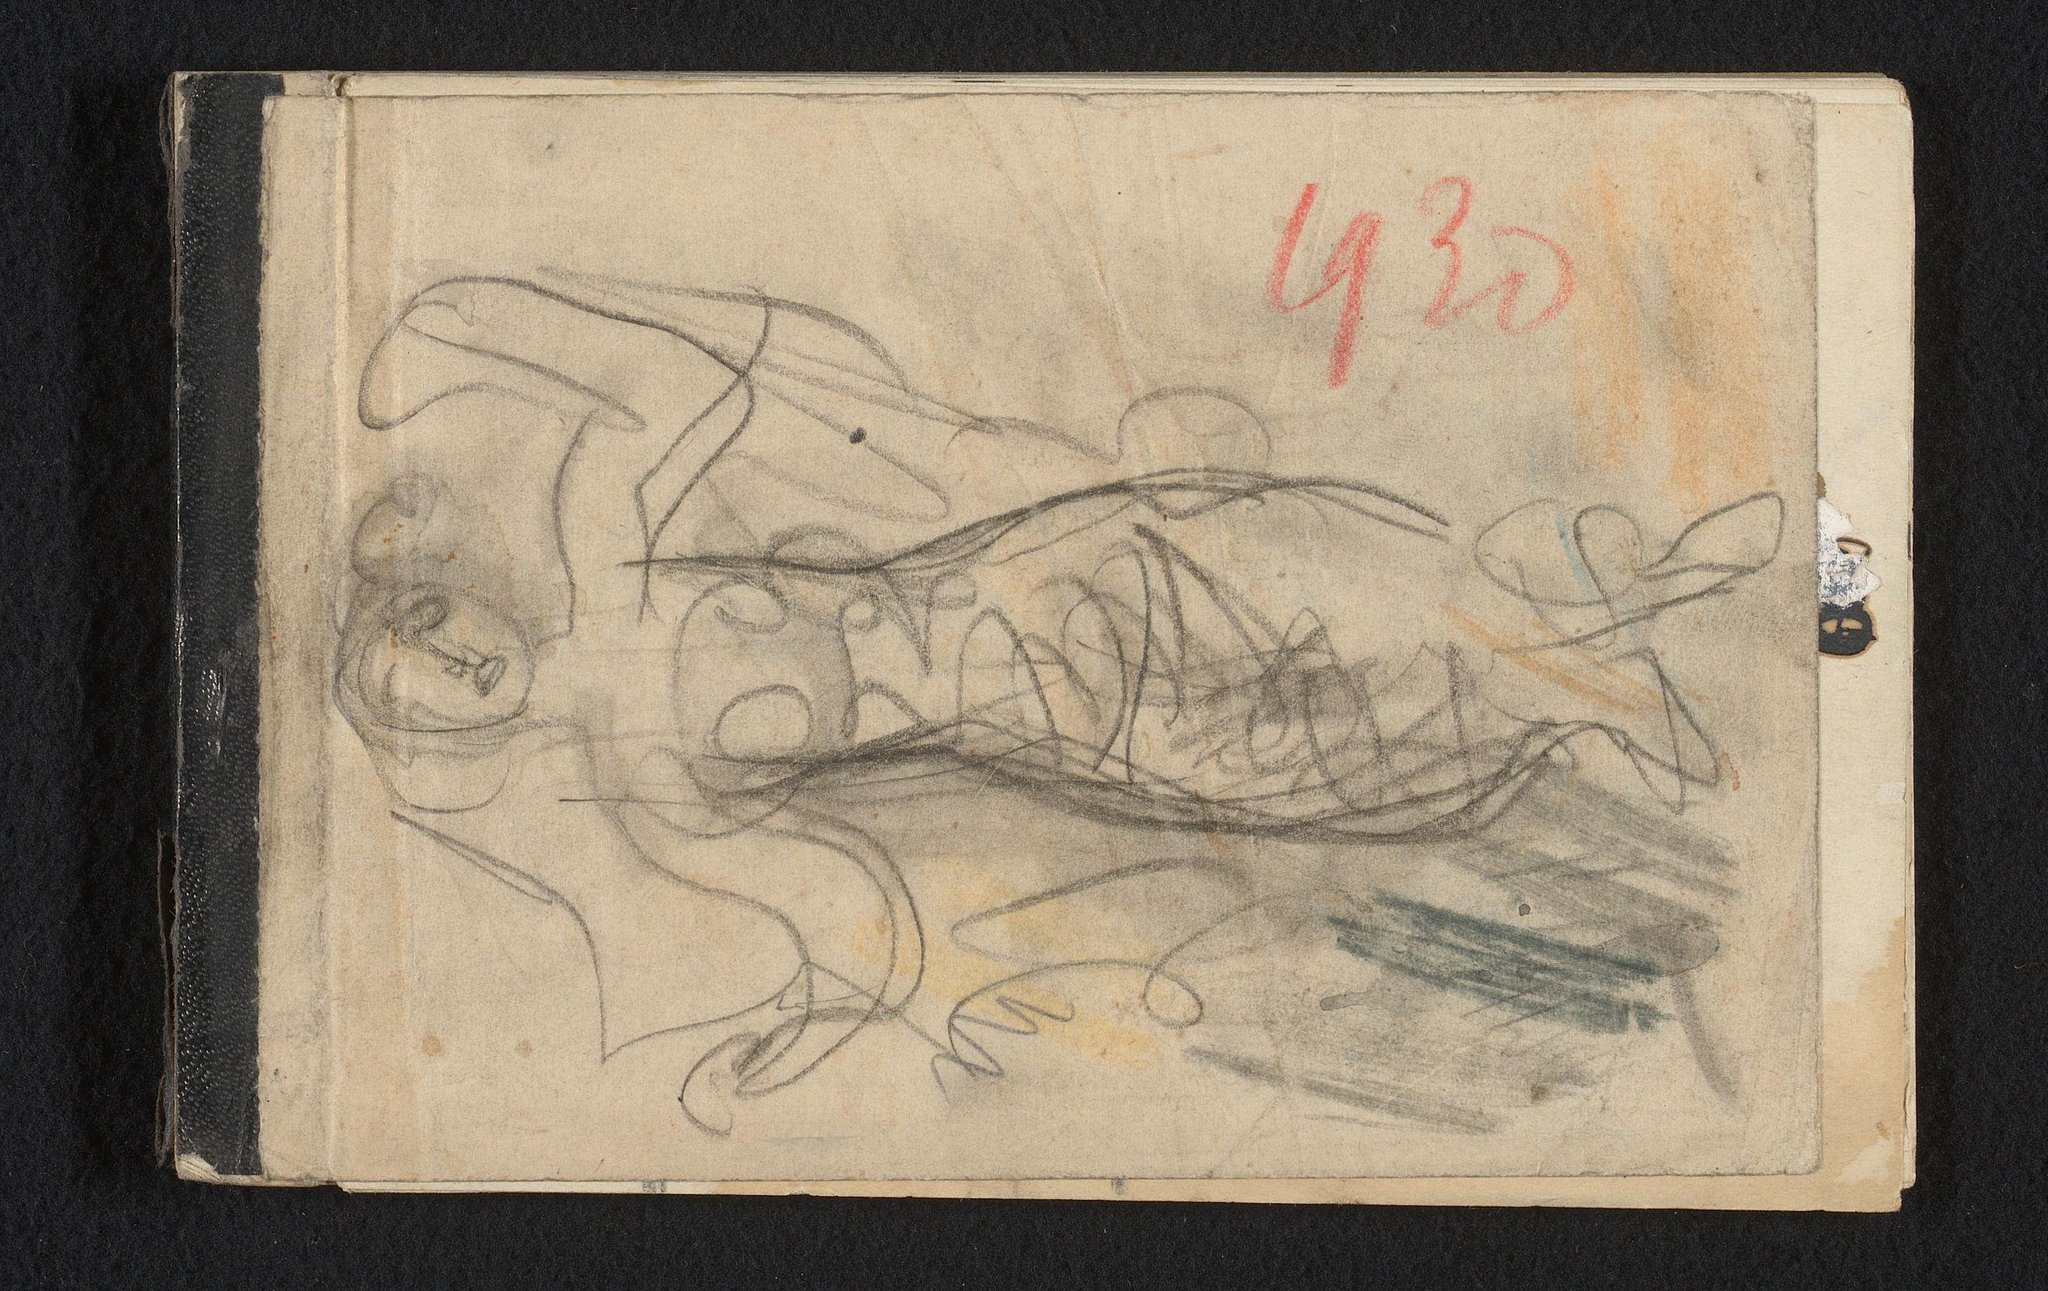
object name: sketchbook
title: Schetsboek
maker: leo gestel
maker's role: draughtsman, print maker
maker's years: 1881-1941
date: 1930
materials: chalk, ink, paper, pencil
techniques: brush, drawing, pen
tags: woman (showing herself) undressed, quasi-nude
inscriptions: date: ‘1930’, workshop stamp: Lugt 1078a, inscription: ‘schetsboek 1930 35 bladen (waarvan 9 los)’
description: Schetsboek met studies van: naakten, koppen, paarden en vogels.